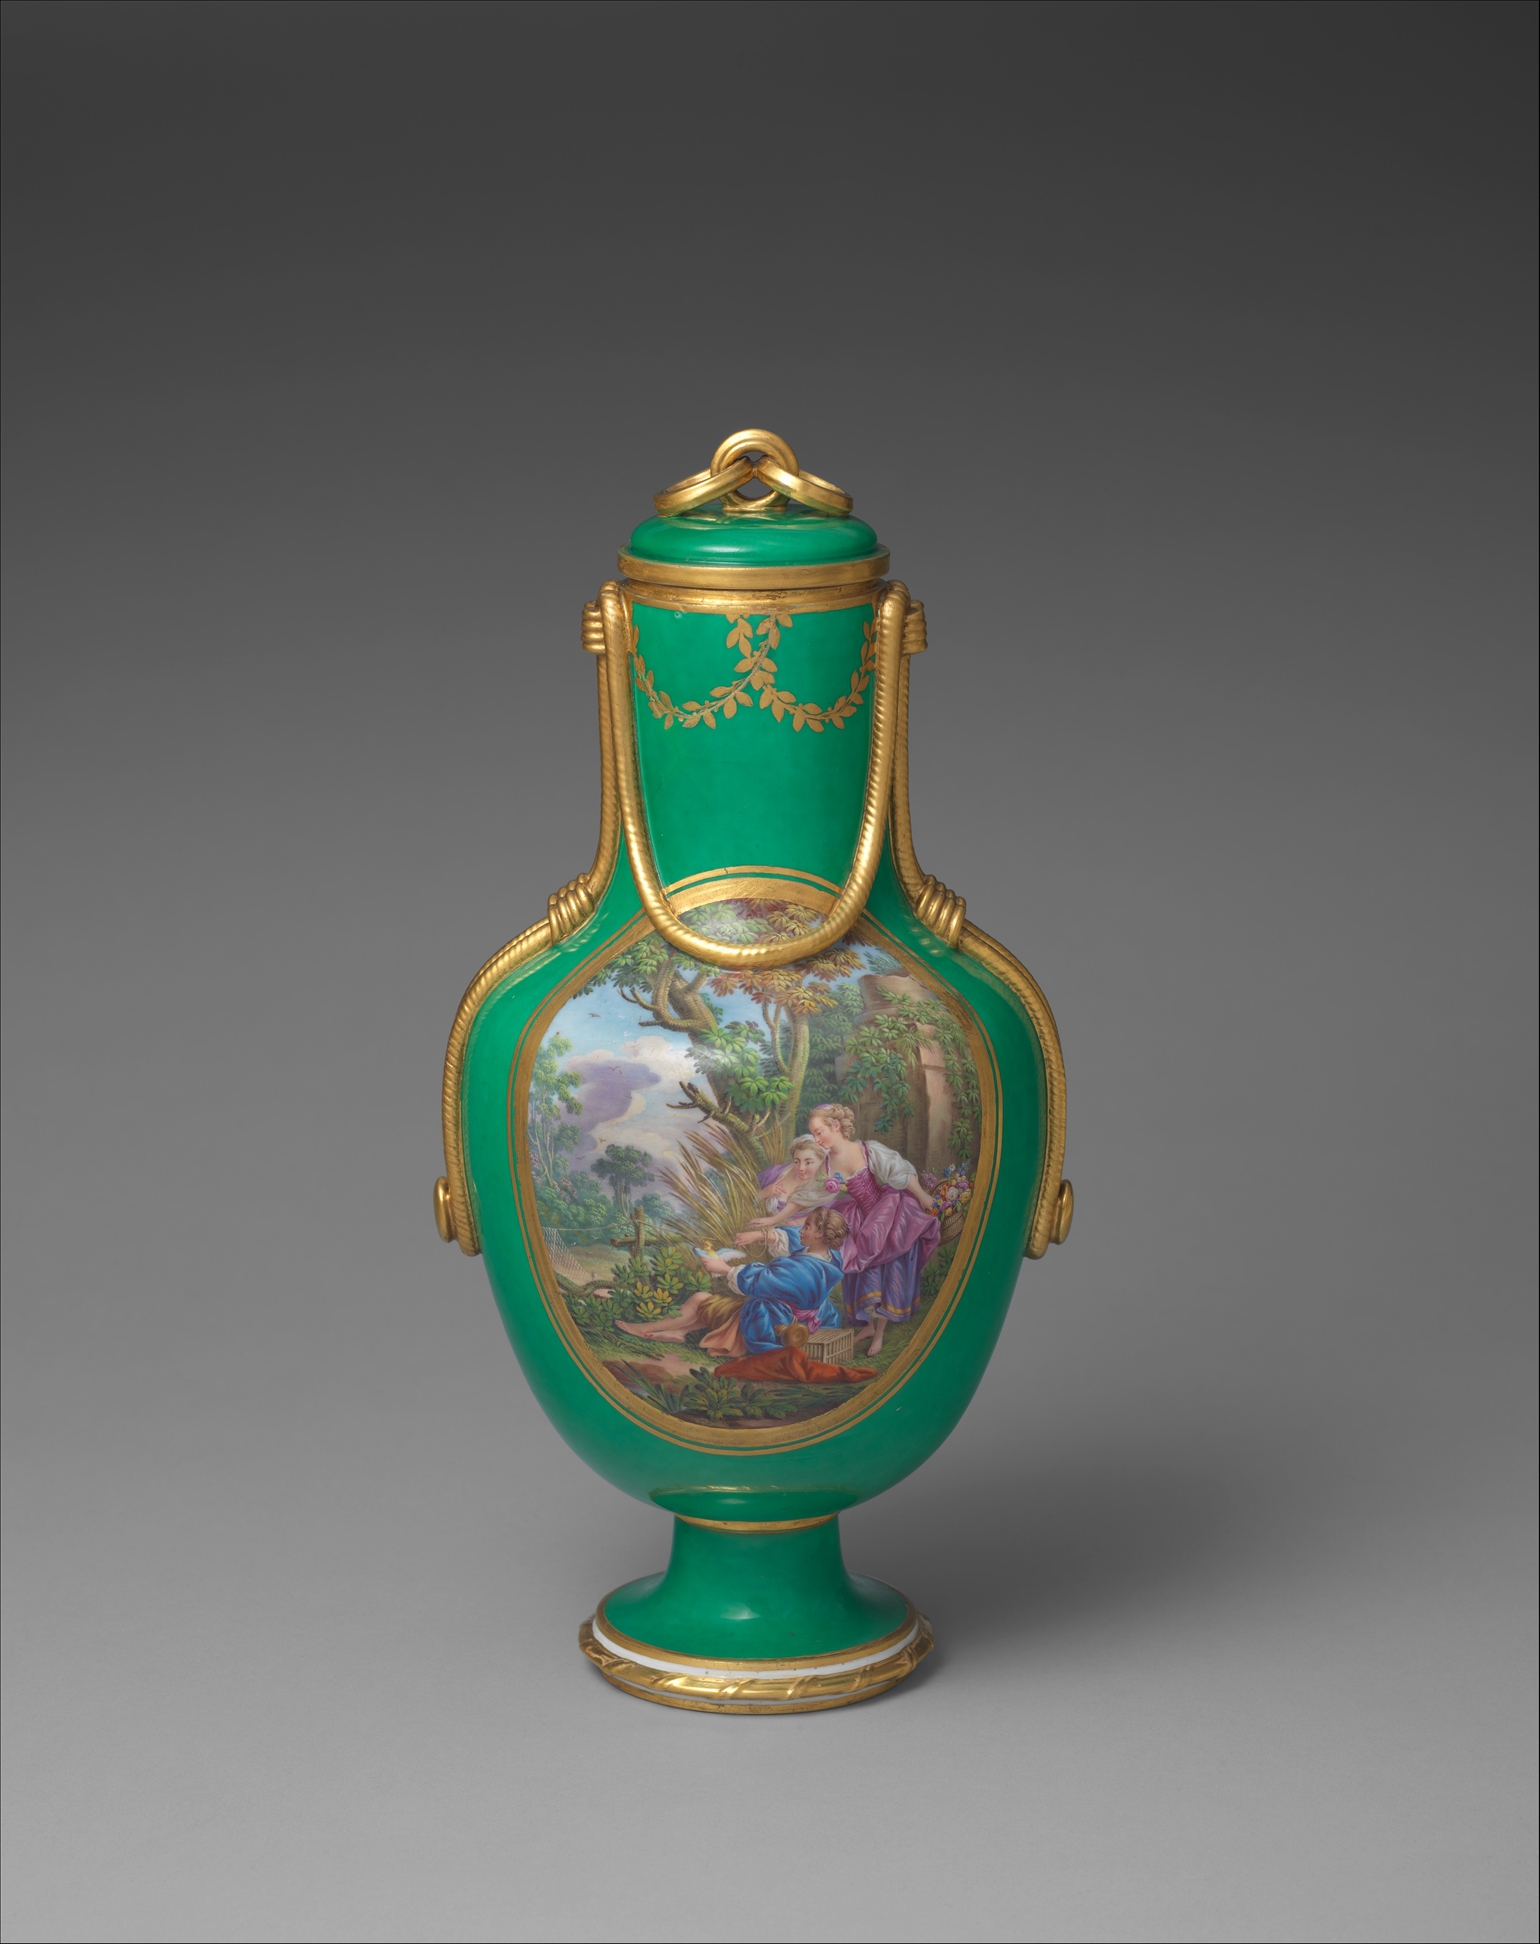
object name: vase with cover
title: Vase with cover (vase à flacon) (one of a pair)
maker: sèvres manufactory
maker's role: manufactory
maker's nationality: french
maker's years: 1740-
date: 1772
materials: soft paste porcelain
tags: women,trees